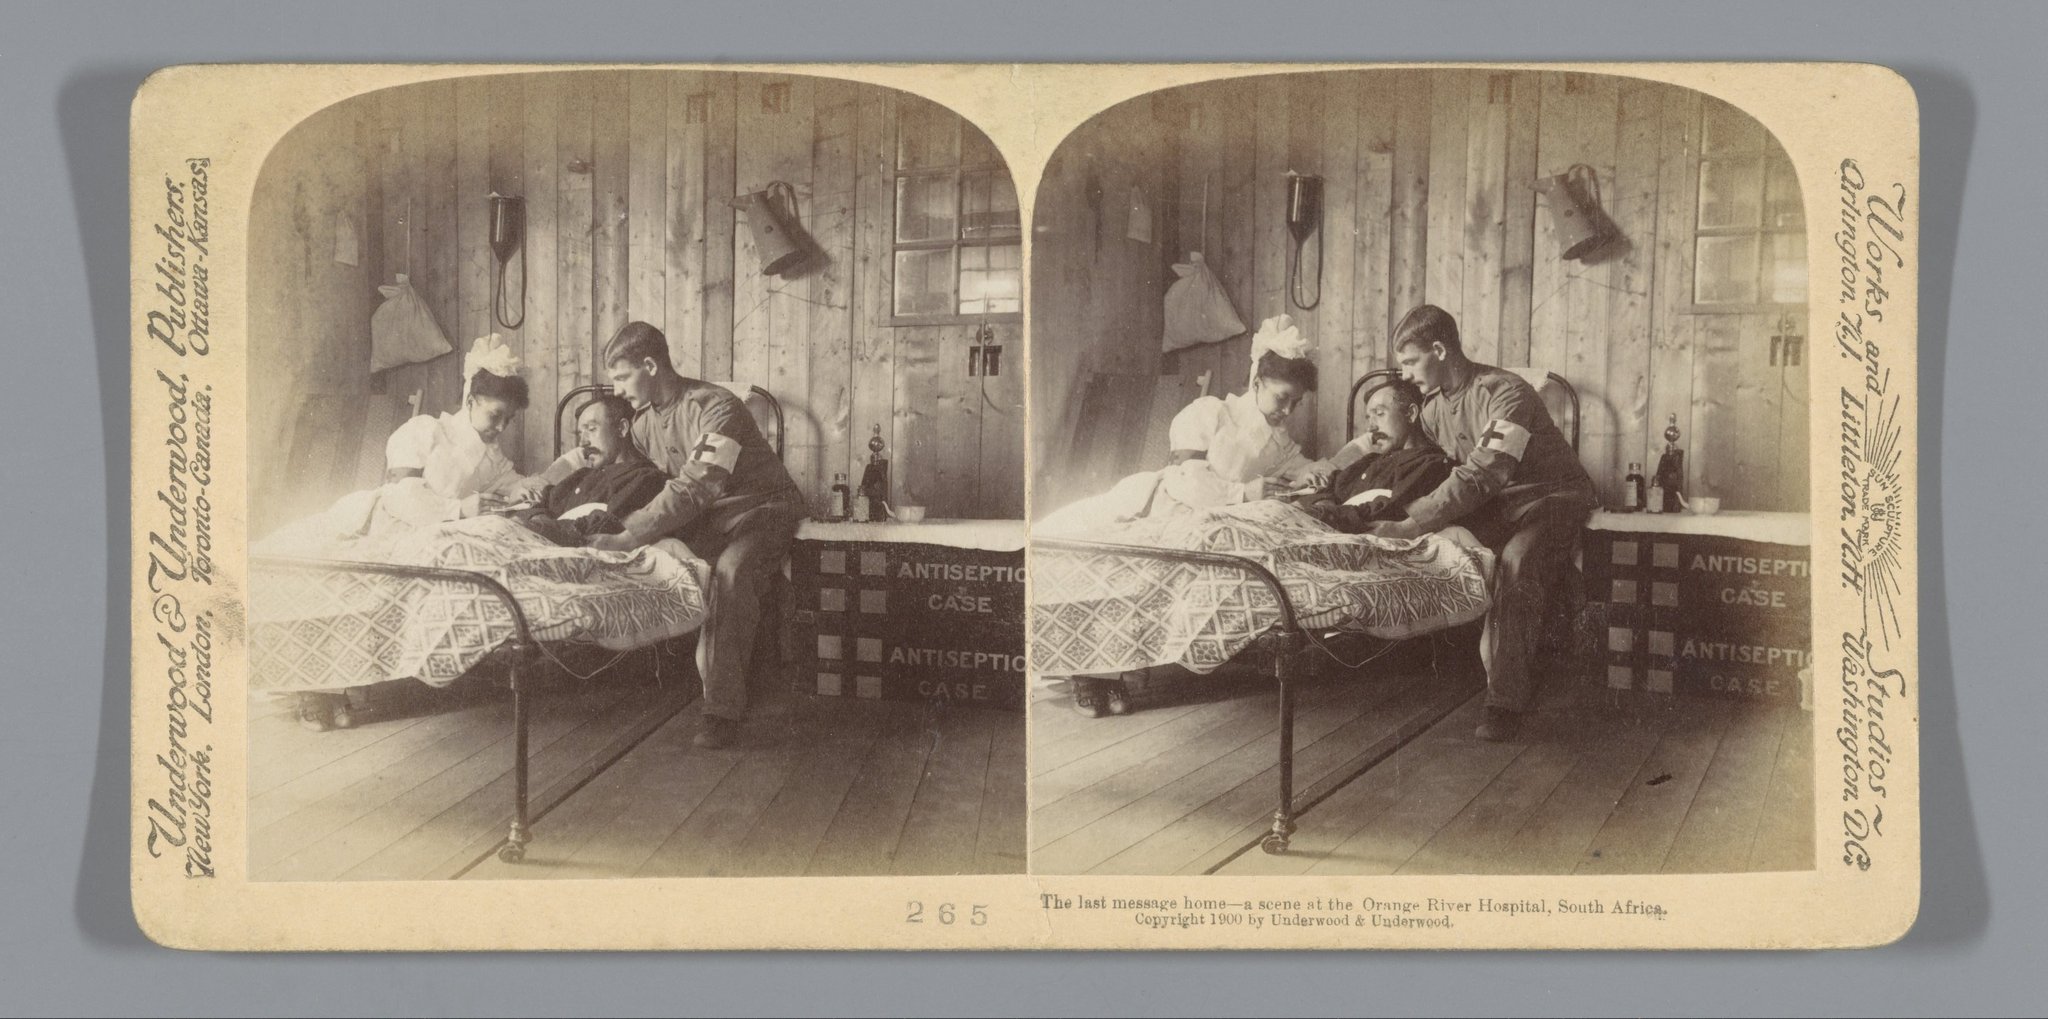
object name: stereograph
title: Gewonde militair schrijft zijn laatste brief naar huis vanuit het Orange River Hospital, Zuid-Afrika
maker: Anonymous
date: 1900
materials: cardboard, paper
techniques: albumen print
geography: orange river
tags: handwriting, writing as activity, medical aid and nursing of the sick and wounded in a lazaretto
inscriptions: copyright notice: ‘Copyright 1900 by Underwood & Underwood.’, inscription: ‘Works and Studios ~/ Arlington, N.J. Littleton, N.H. Washington, D.C.’, inscription, number: ‘265’